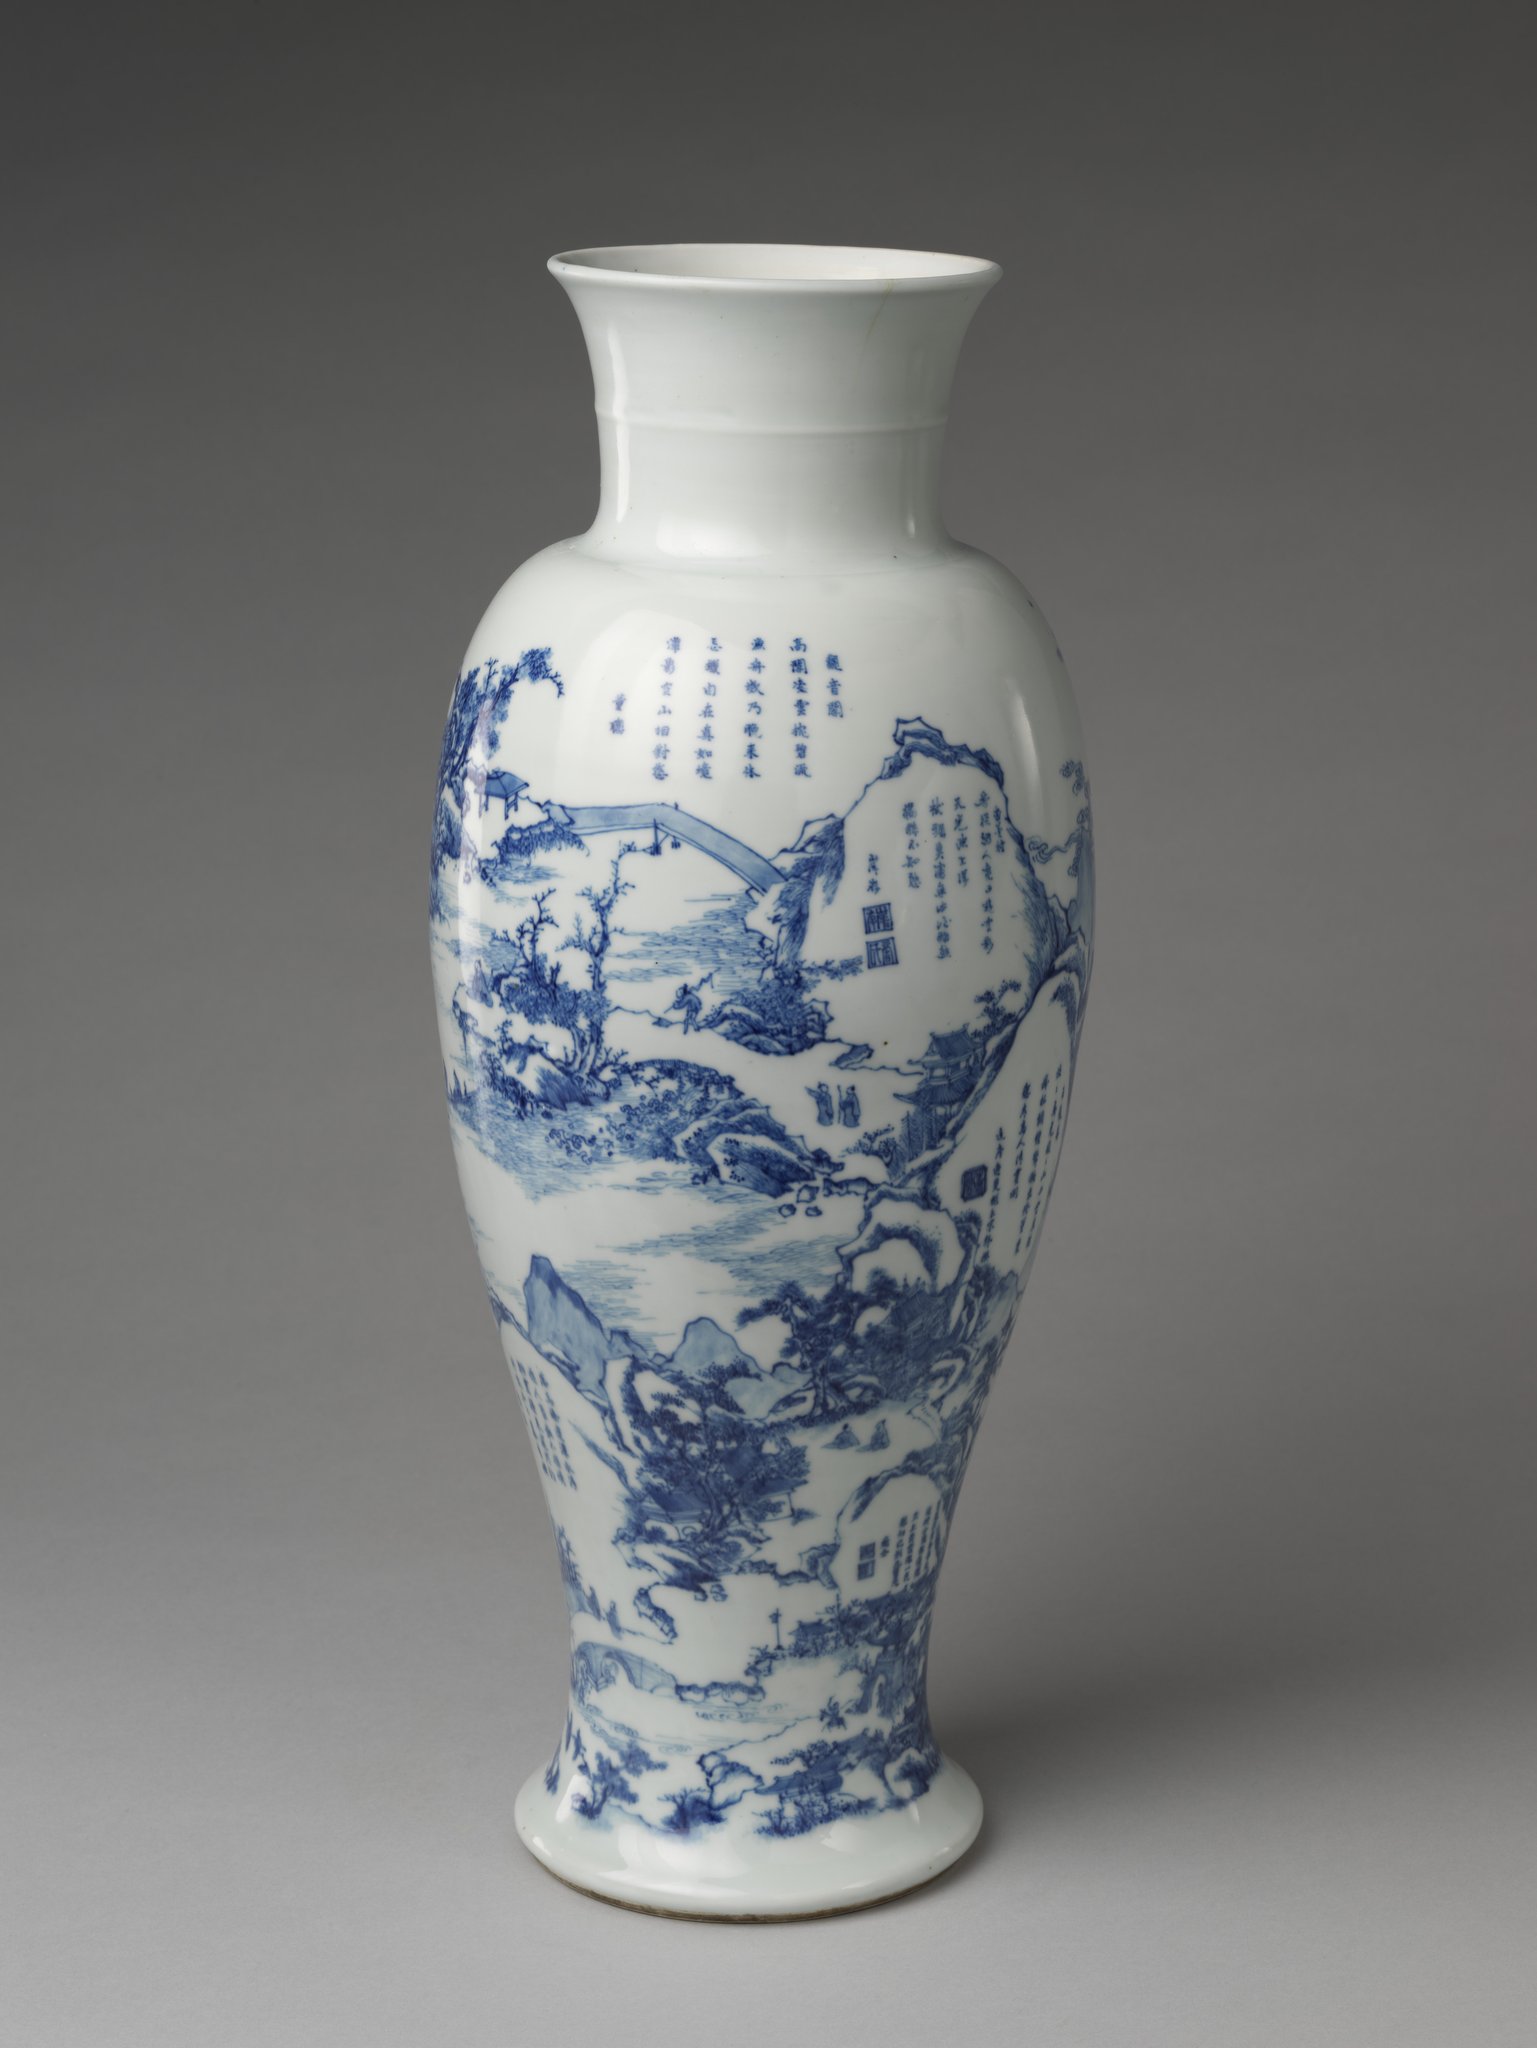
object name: vase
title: Vase with poems in a panoramic landscape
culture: chinese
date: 1667-1700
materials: cobalt, glaze, porcelain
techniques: painting